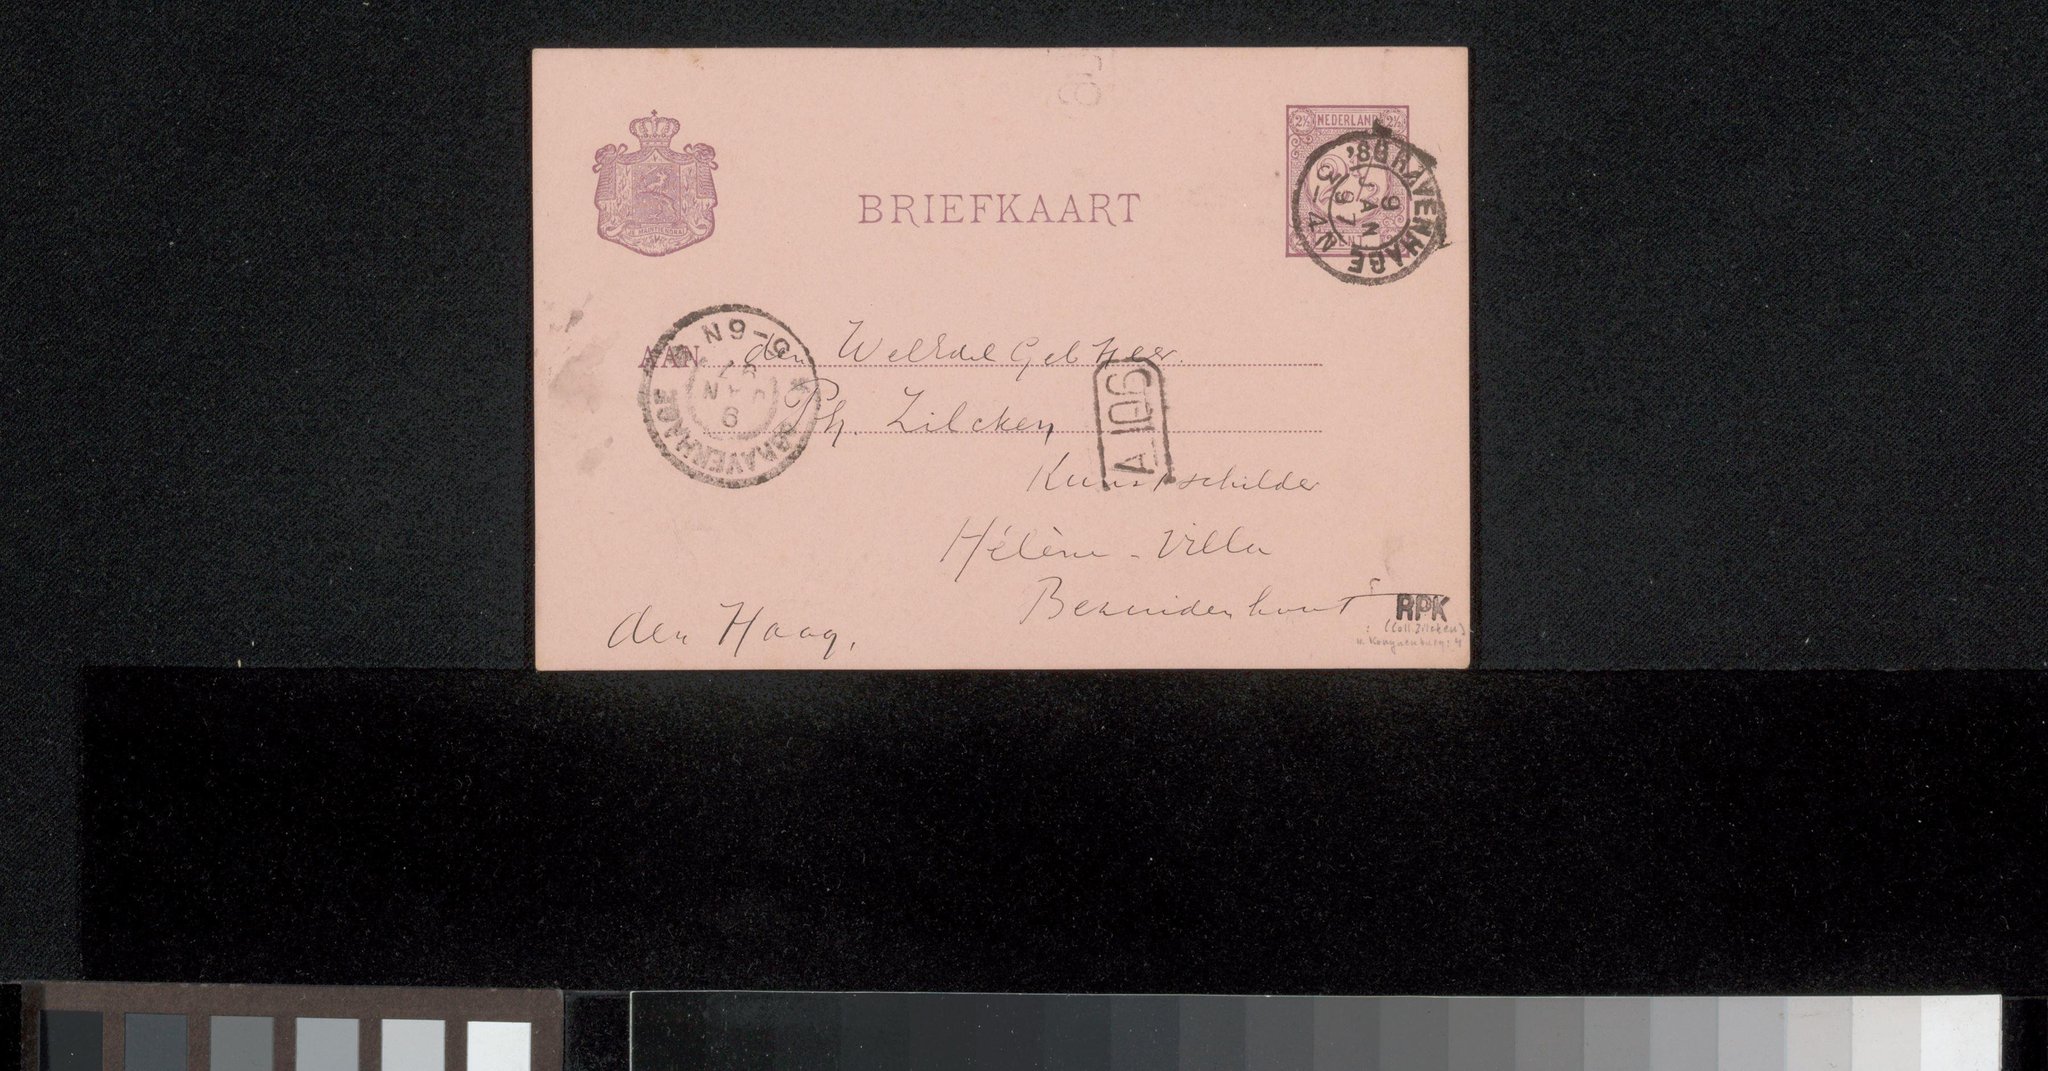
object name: postcard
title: Briefkaart aan Philip Zilcken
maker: willem van konijnenburg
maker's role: draughtsman, painter, print maker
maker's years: 1868-1943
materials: cardboard, ink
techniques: pen, writing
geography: the hague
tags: painter, draughtsman, philip zilcken, literature ~ arts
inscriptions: collector's mark: ‘RPK’